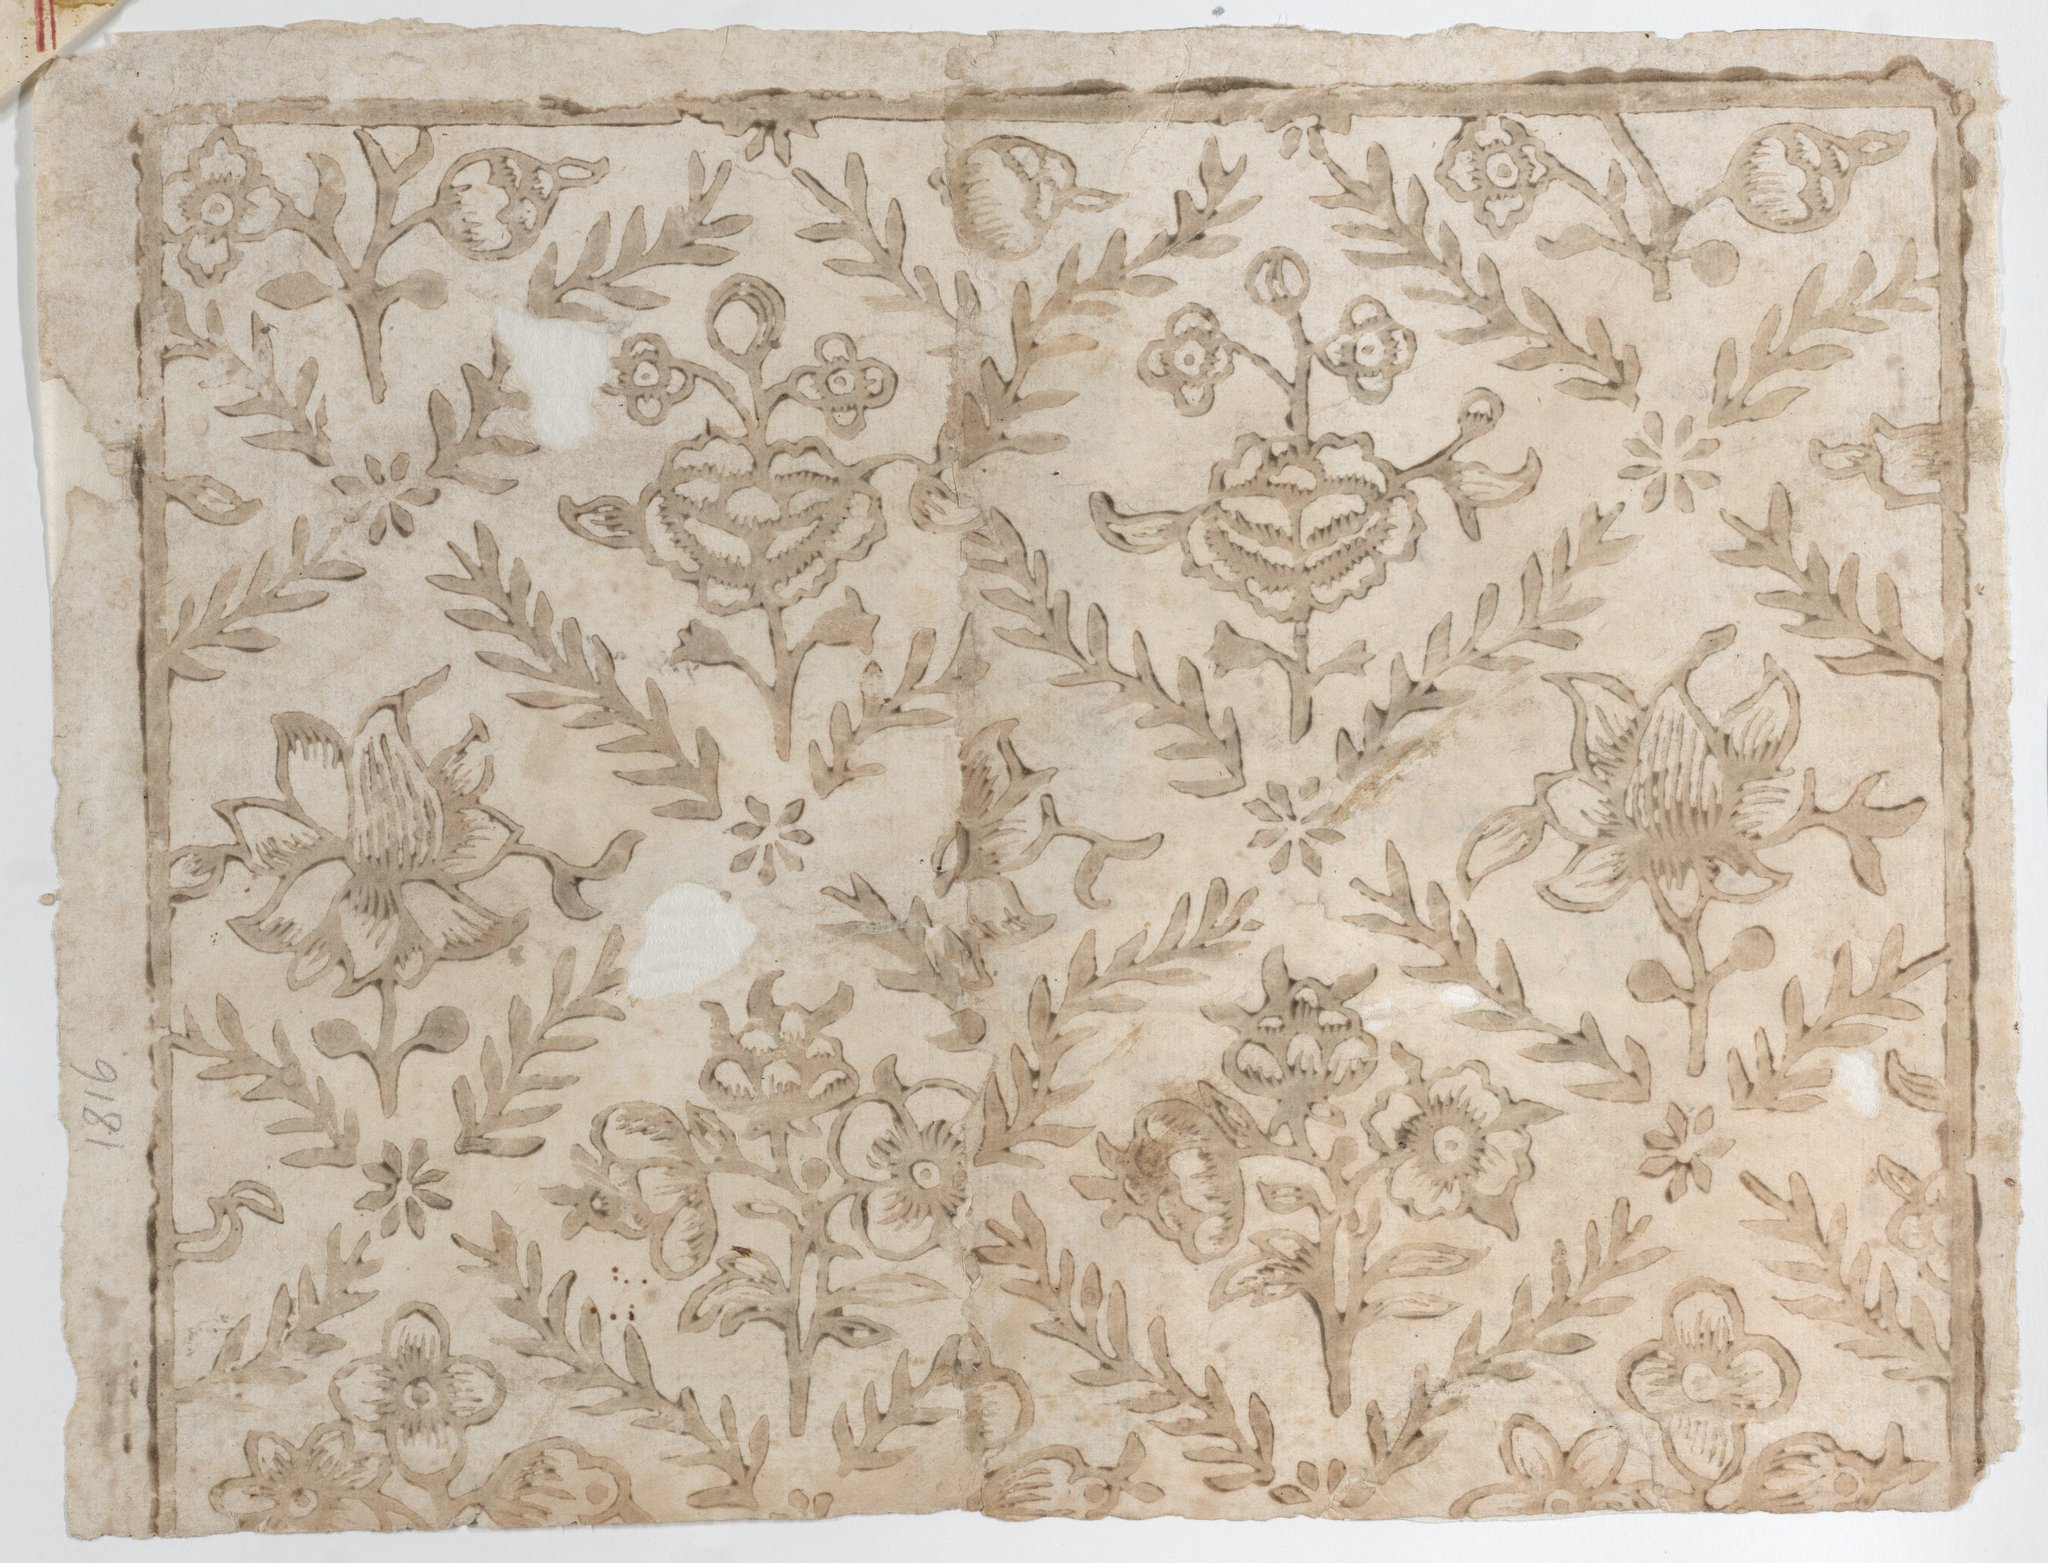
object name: print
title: Sheet with brown floral pattern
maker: Anonymous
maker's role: artist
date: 1701-1800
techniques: relief print